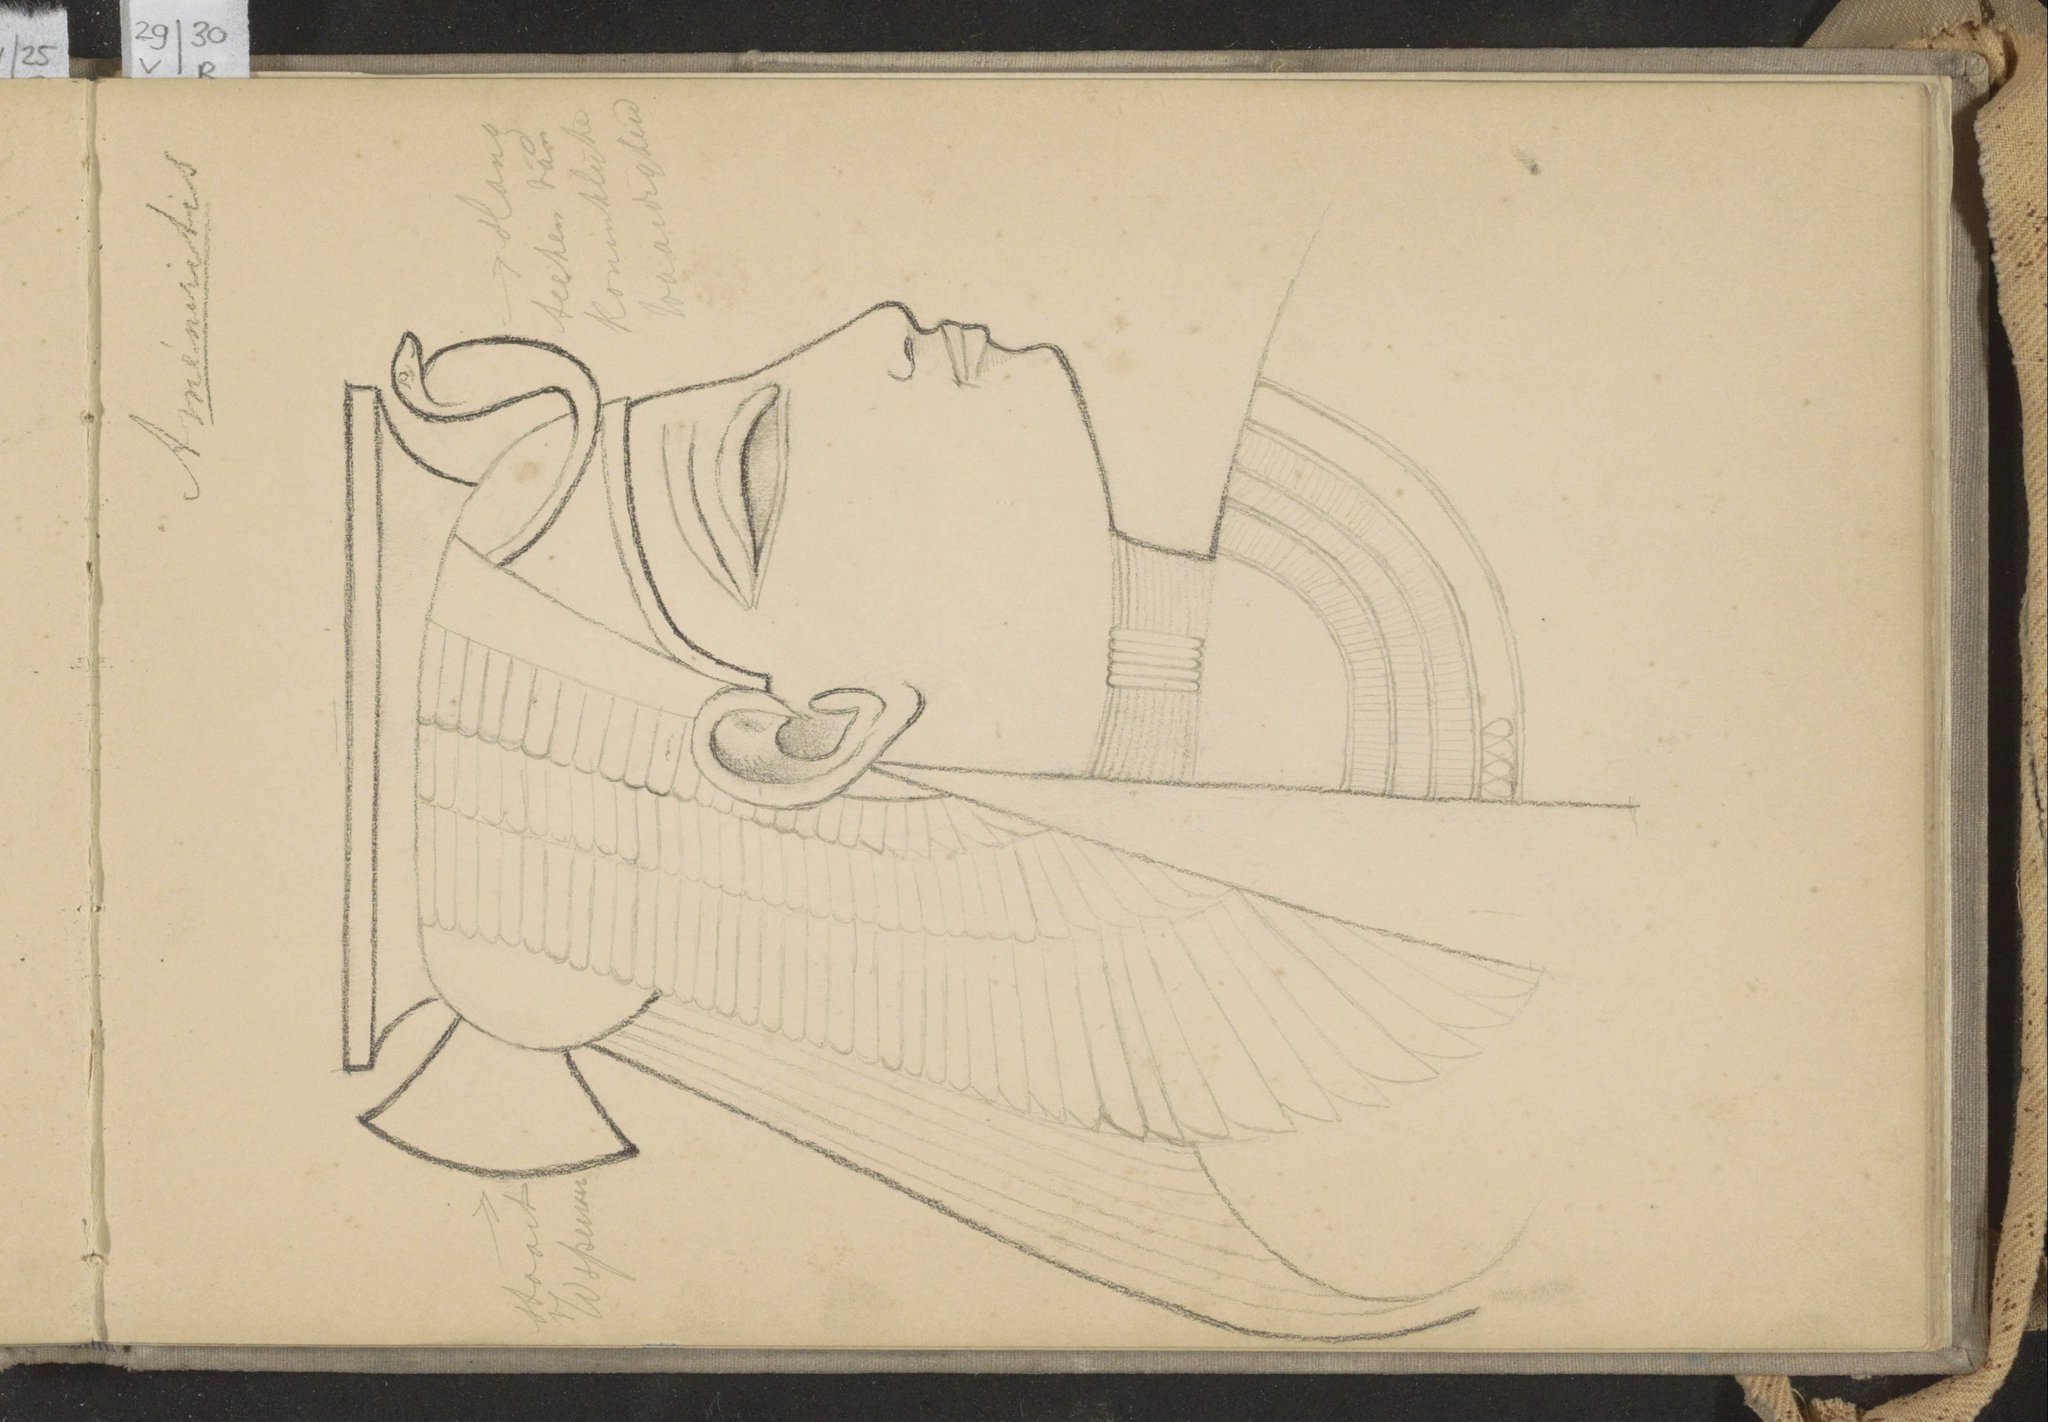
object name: sketchbook leaf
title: Hoofd van een farao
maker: johanna van de kamer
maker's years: 1873-1922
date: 1890-1922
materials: paper, pencil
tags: ruler, sovereign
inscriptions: annotation: ‘Amén[...]tis/ staart/ [...]speuren/ slang/ teeken van/ koninklijke/ waardigheid’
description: De farao draagt een hoofddeksel met slang. Blad 28 recto uit een schetsboek met 43 bladen.